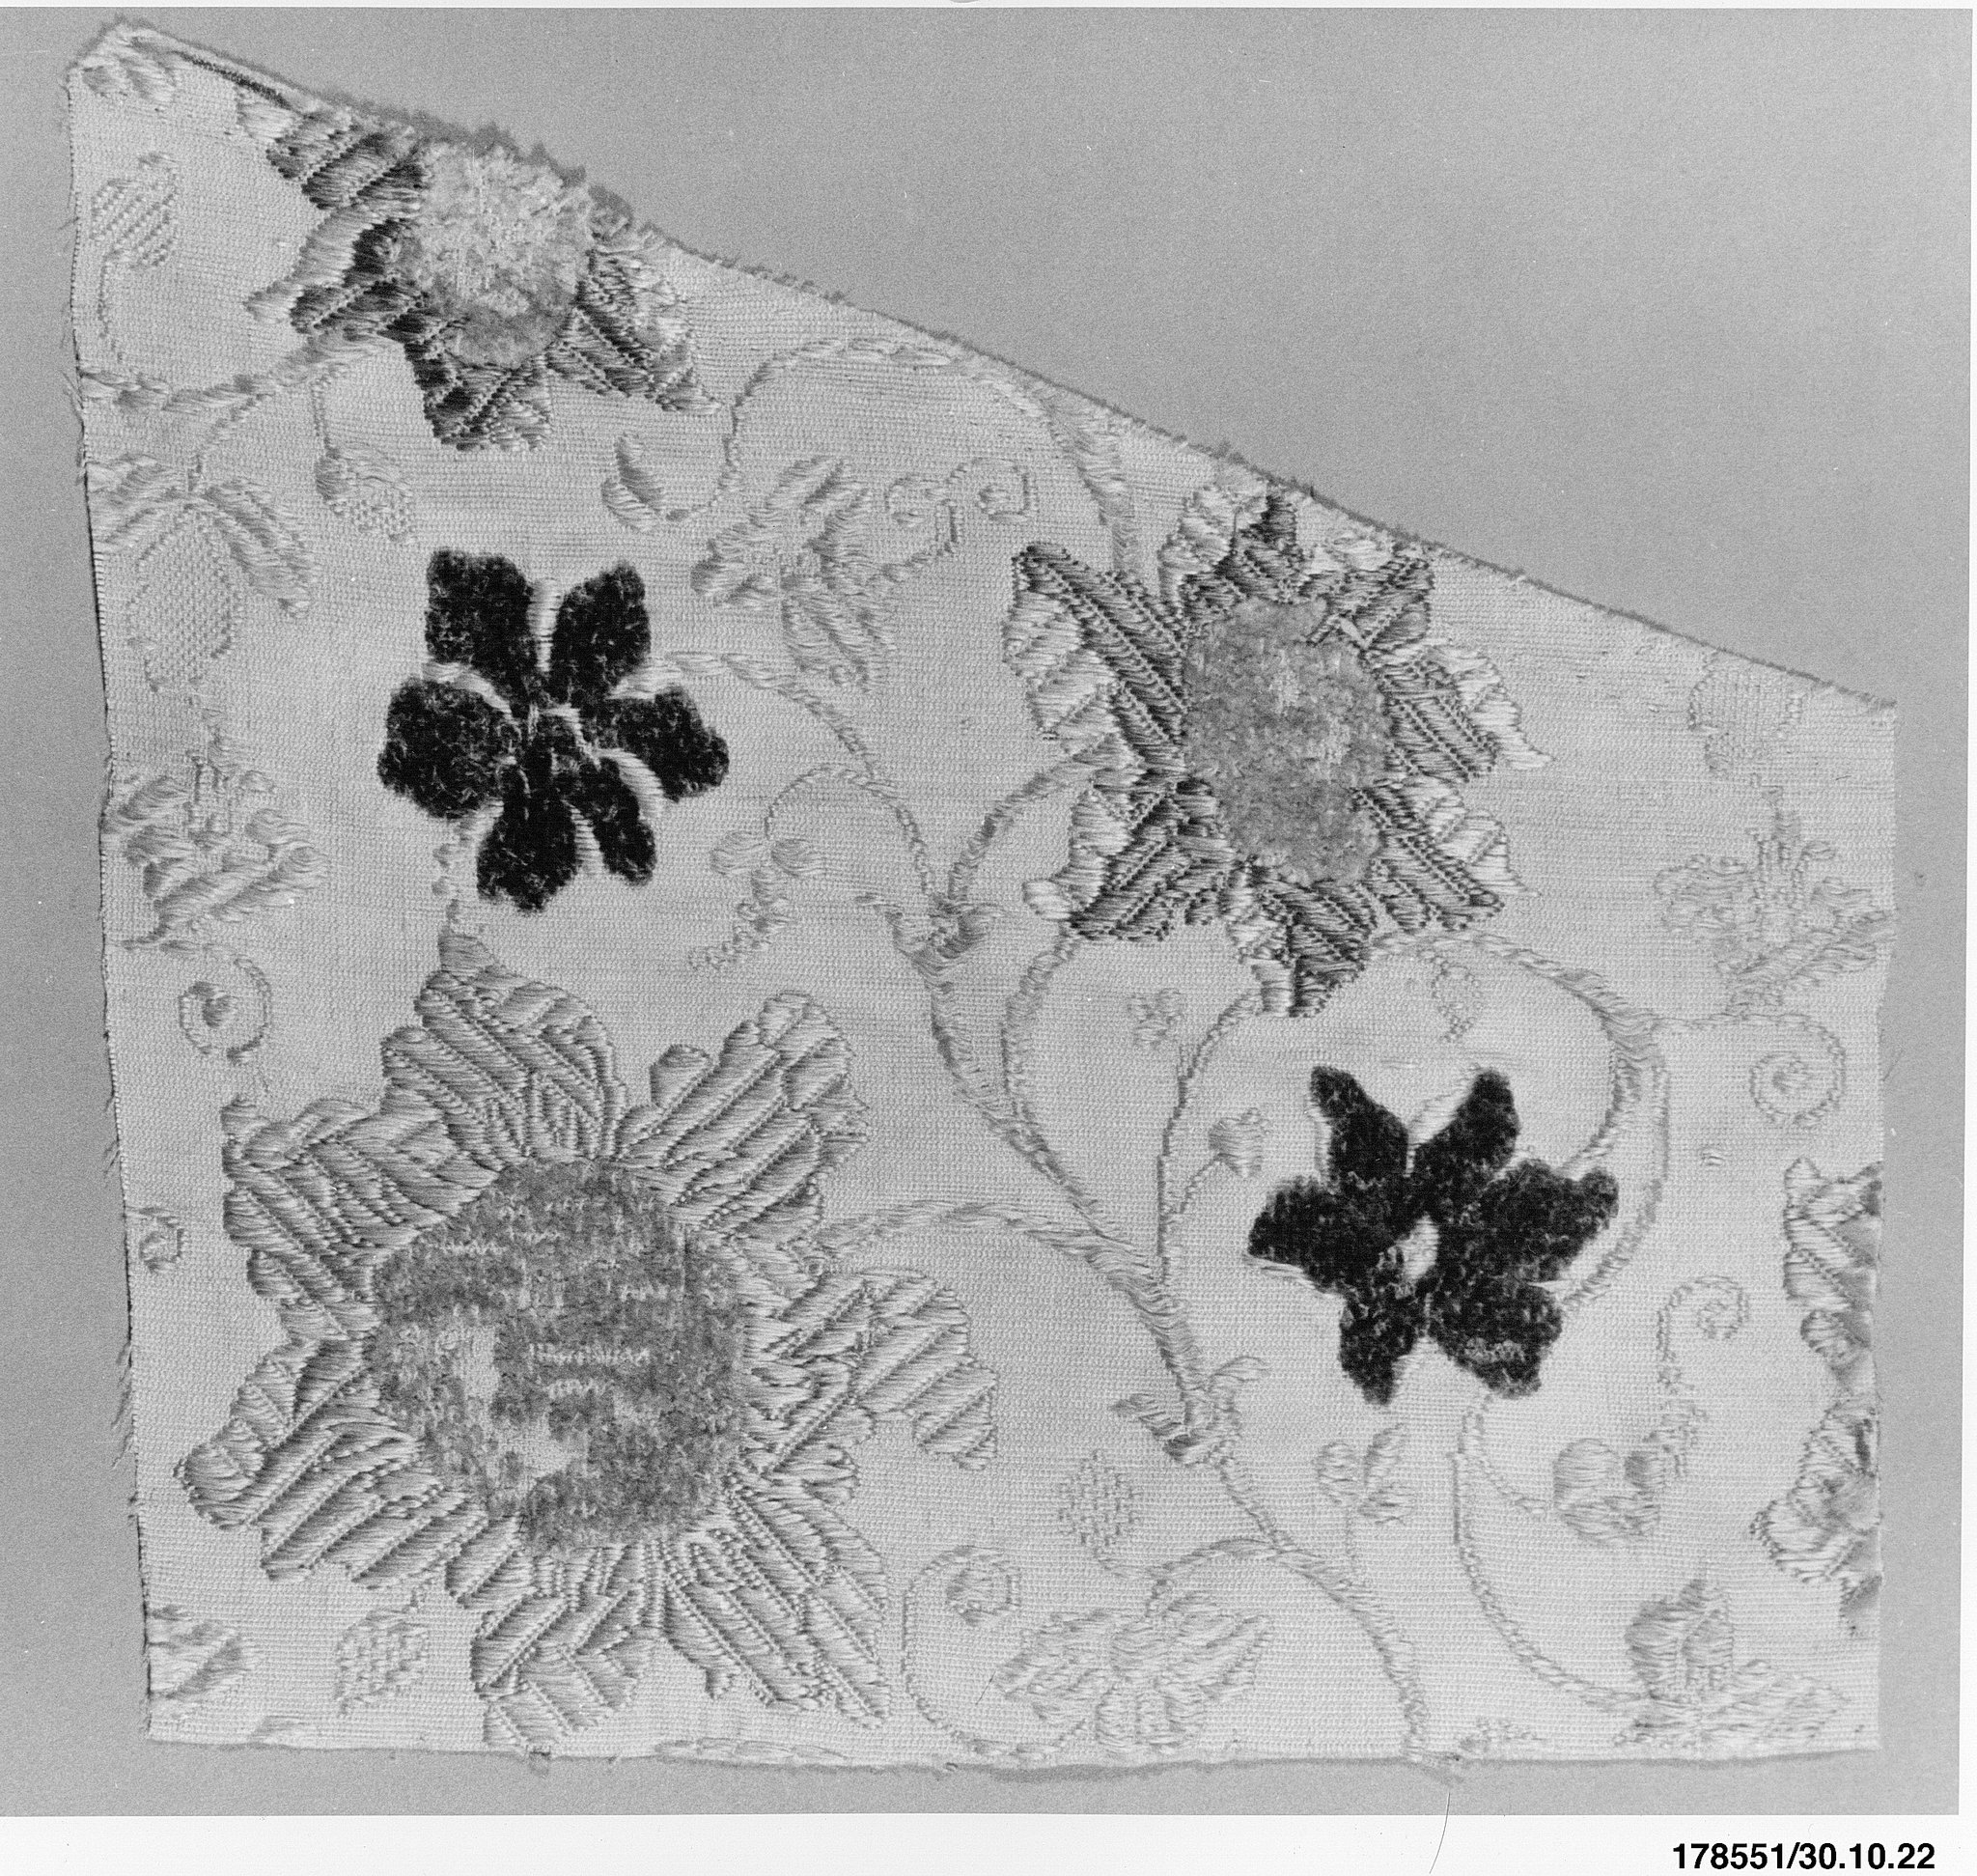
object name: piece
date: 1701-1800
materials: silk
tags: flowers